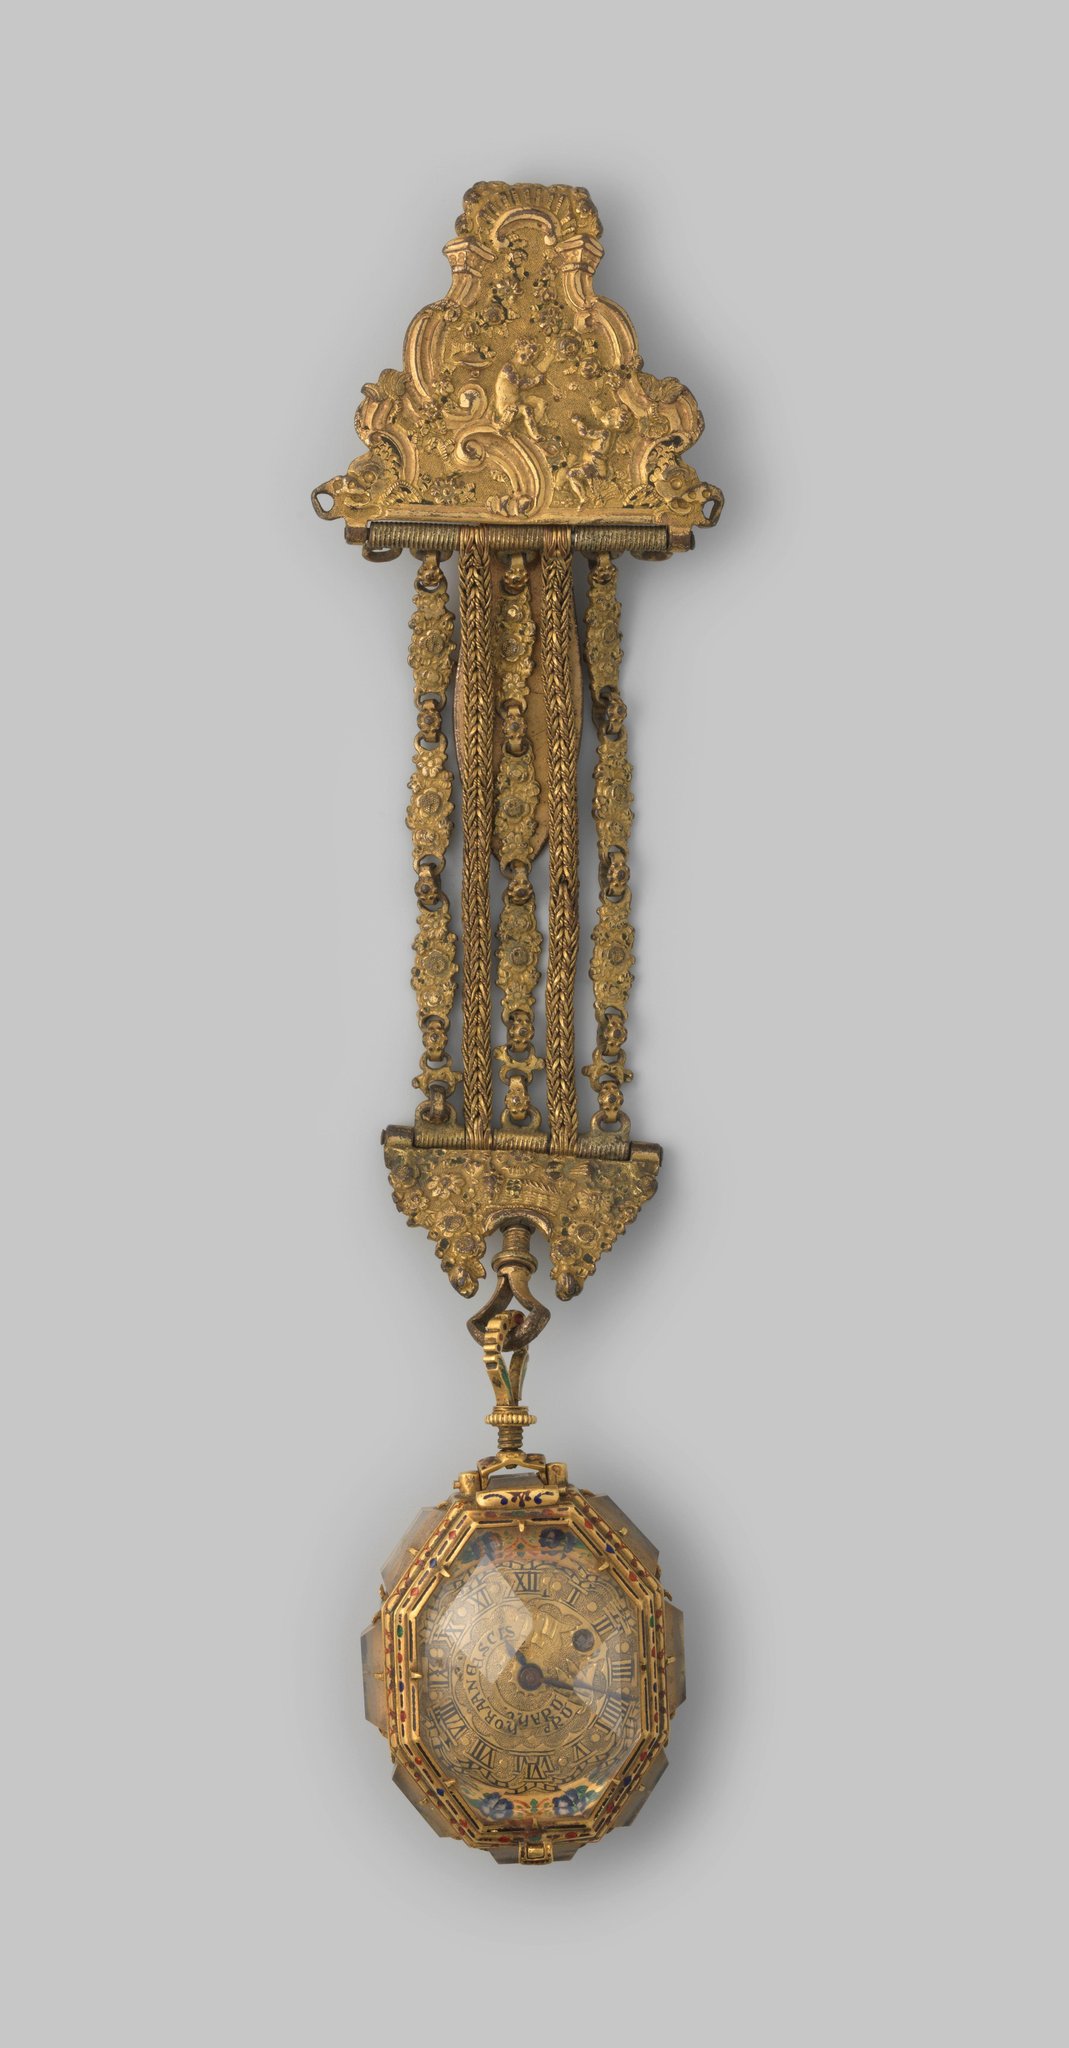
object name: chatelaine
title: Achtkantig kristallen horloge met op de achterzijde een email versiering van vogels en guirlandes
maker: karl komenda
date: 1800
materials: copper, crystal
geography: vienna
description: Achtkantig kristallen horloge met koperen chatelaine. Op de achterzijde (van het horloge ?) een email versiering van vogels en guirlandes.